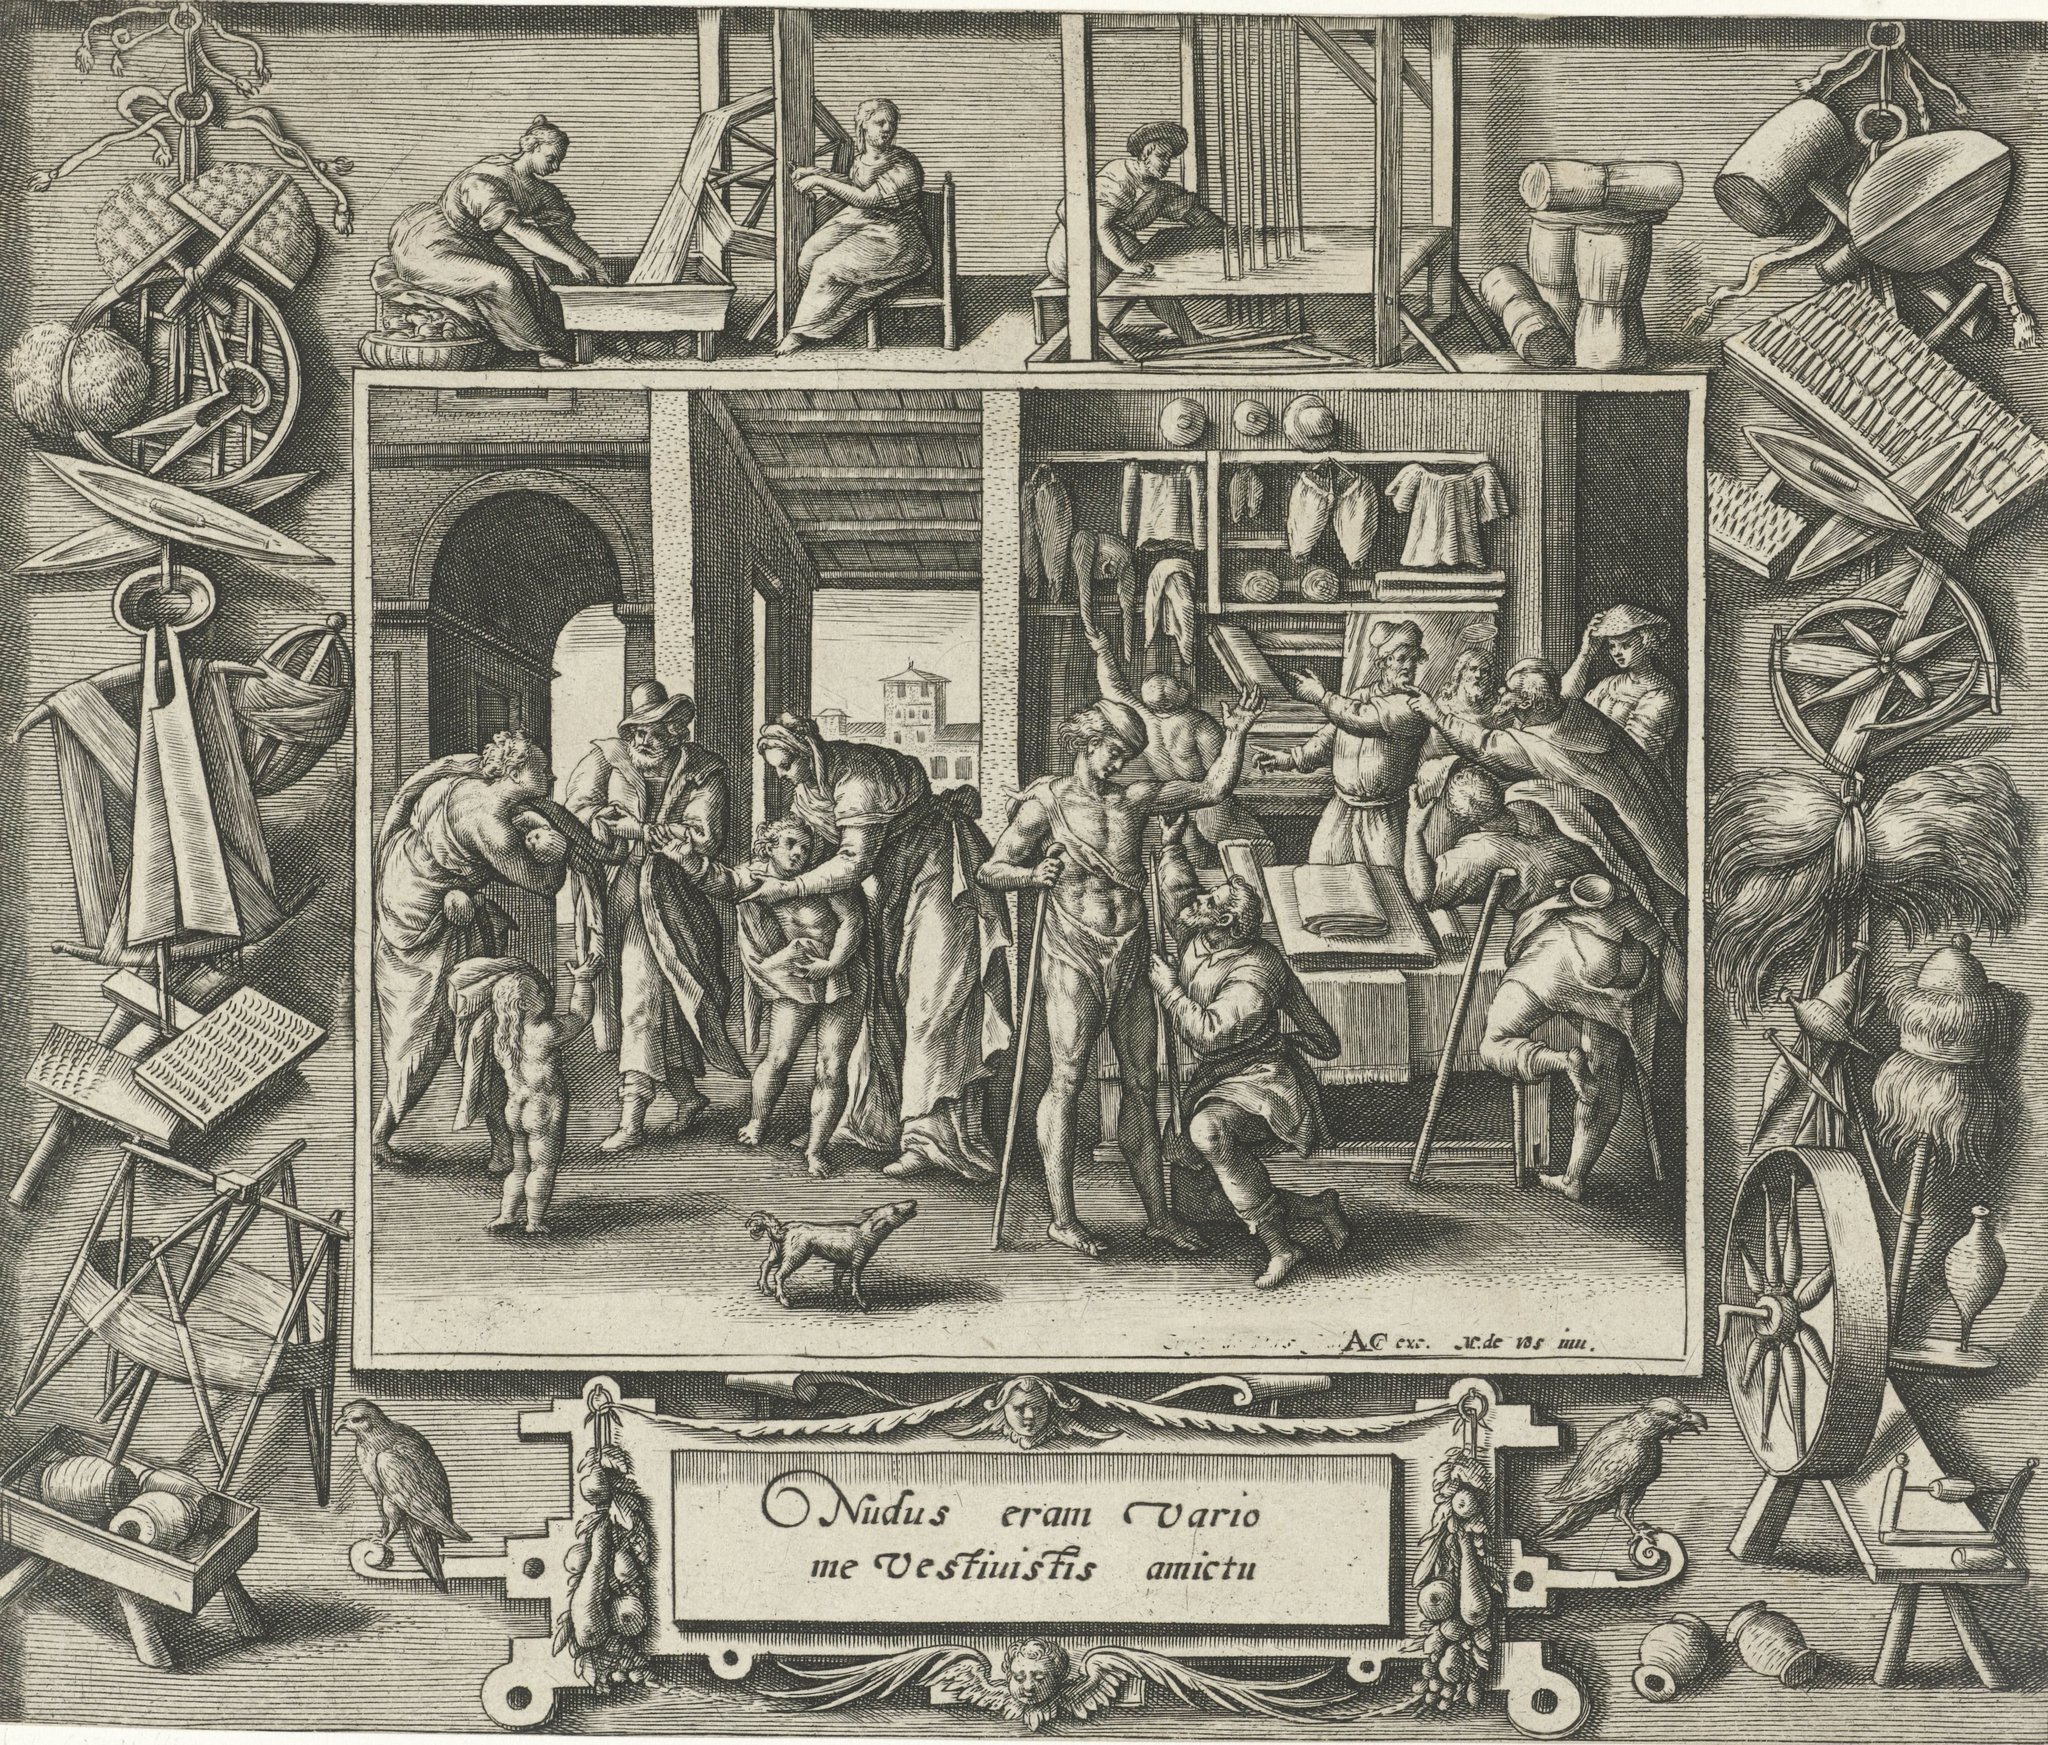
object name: print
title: Het Laatste Oordeel en de zeven werken van barmhartigheid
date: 1580-1588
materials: paper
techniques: engraving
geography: antwerp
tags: wool (material ~ textile industry) (+ labourers ~ crafts, industries, agriculture), clothing the naked, 'nudus vestitur' ~ one of the (seven) acts of mercy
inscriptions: collector's mark: Lugt 240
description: Een vrouw helpt een kind in een jas. Een man staat in een stal waarin allerlei kledingstukken aangeboden worden. Een naakte man heft in wanhoop zijn arm ten hemel. De prent heeft een ornamentele rand die is versierd met alle benodigdheden voor het produceren van wol. Prent uit een serie van acht met het Laatste Oordeel en de zeven werken van barmhartigheid.